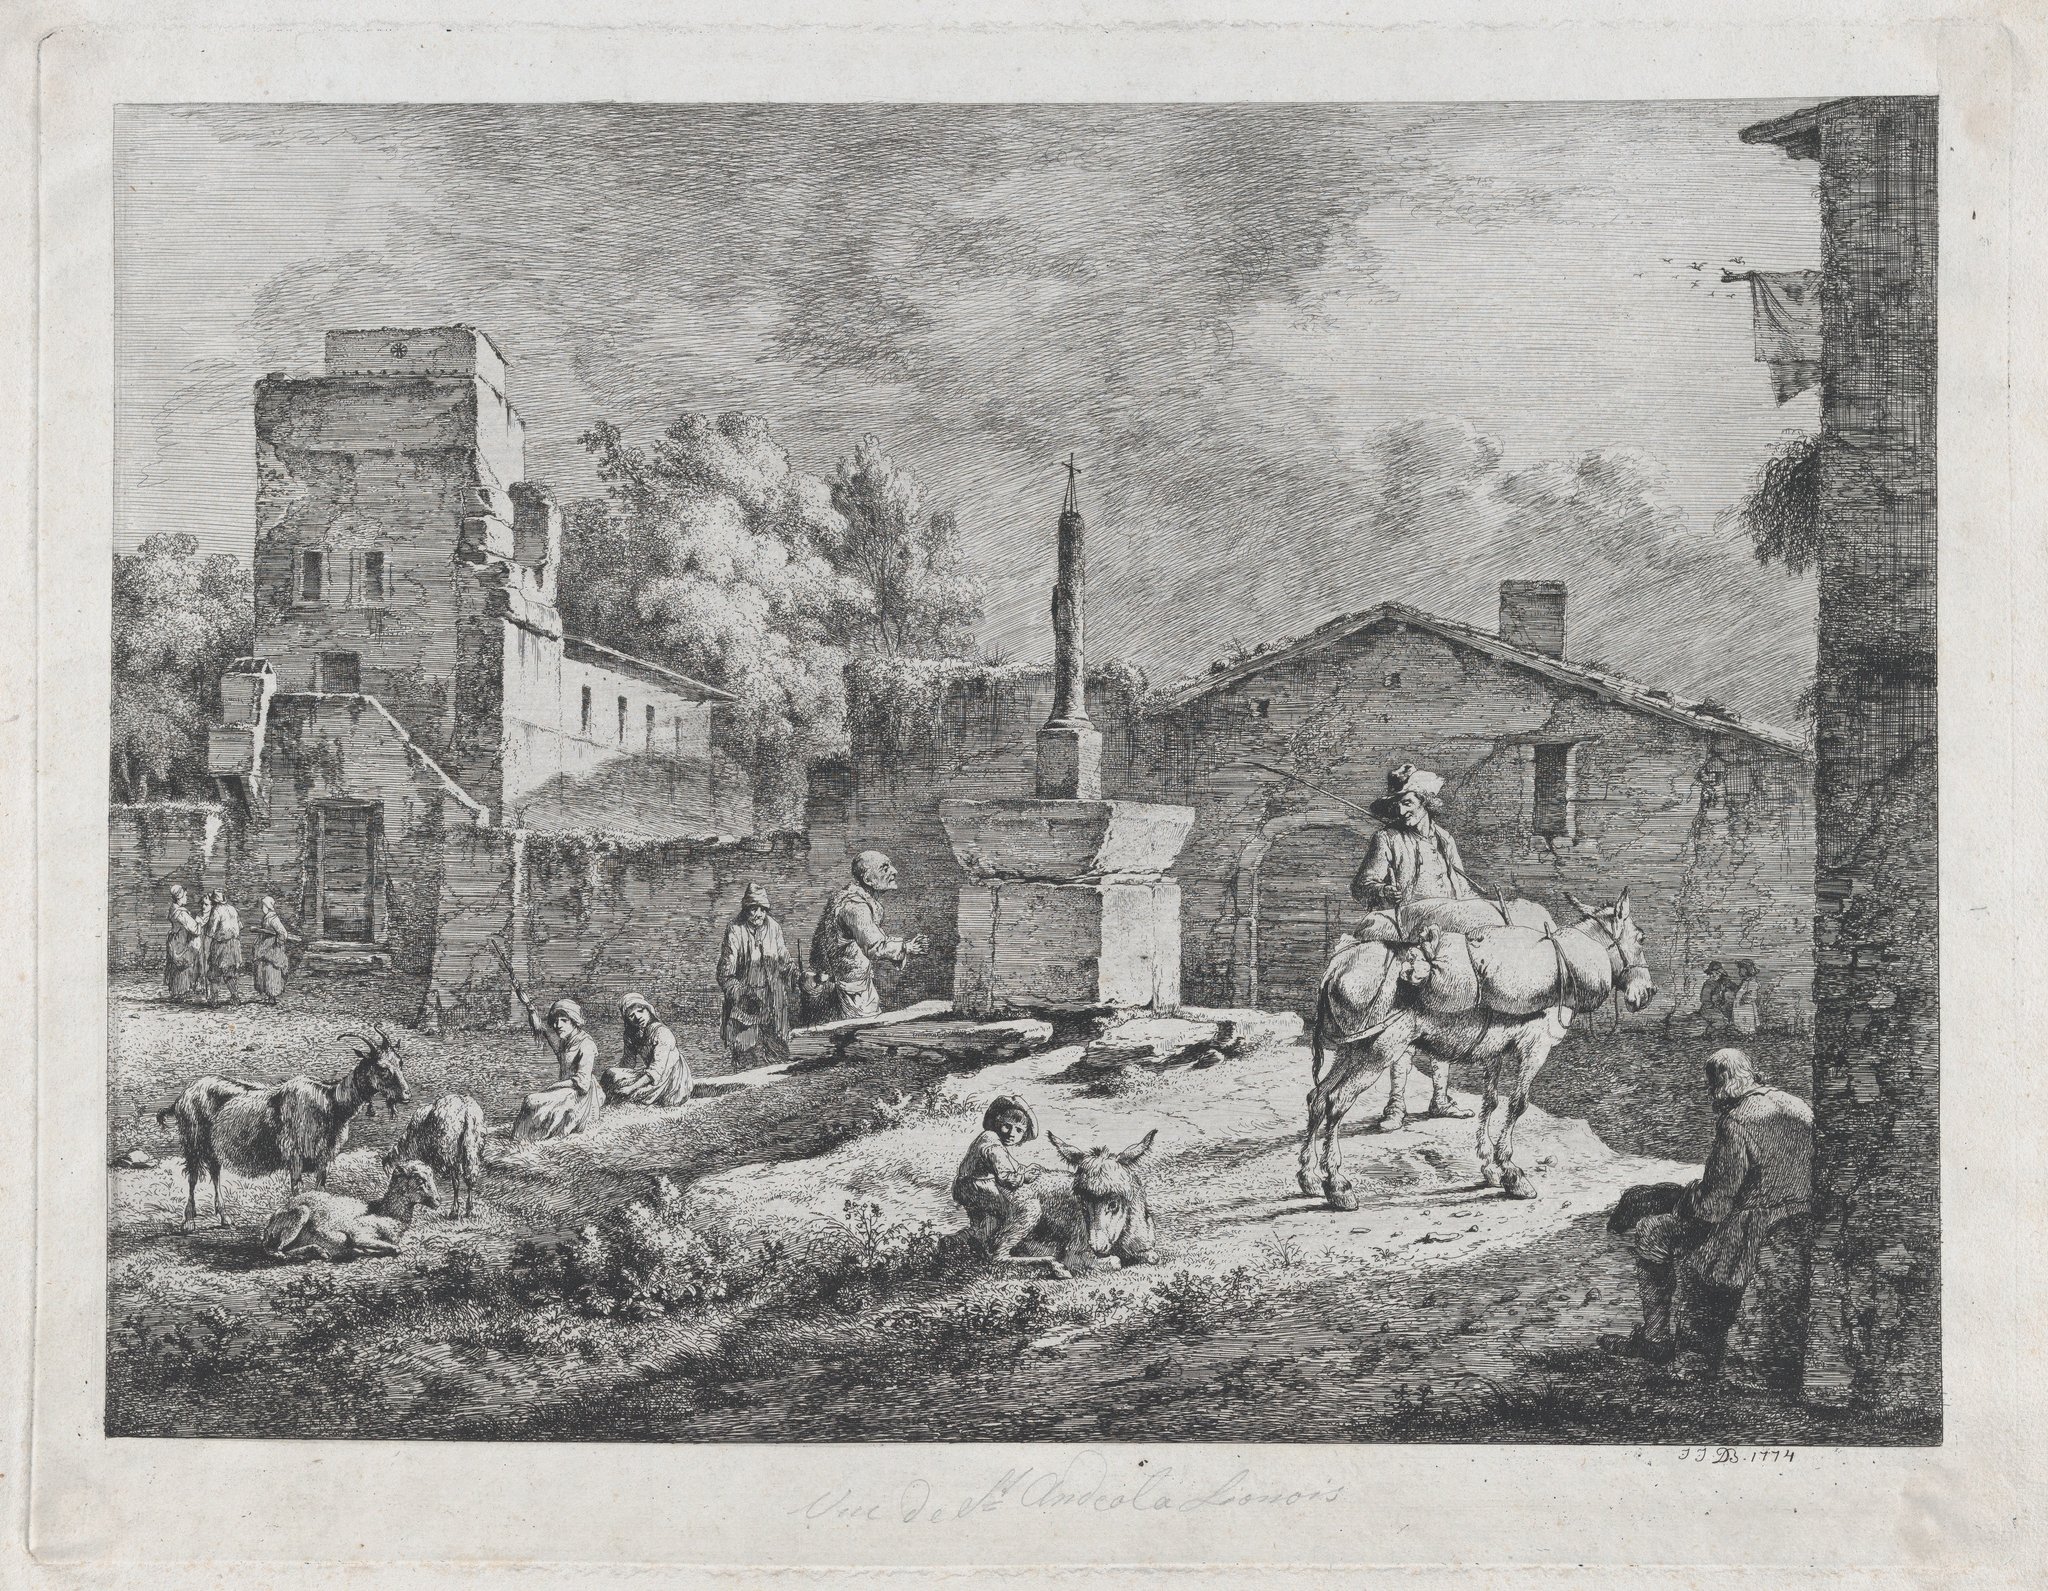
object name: print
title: View of Saint-Andéol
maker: jean jacques de boissieu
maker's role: artist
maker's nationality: french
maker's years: 1736-1810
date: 1774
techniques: drypoint, etching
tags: animals,buildings,men,women,horses